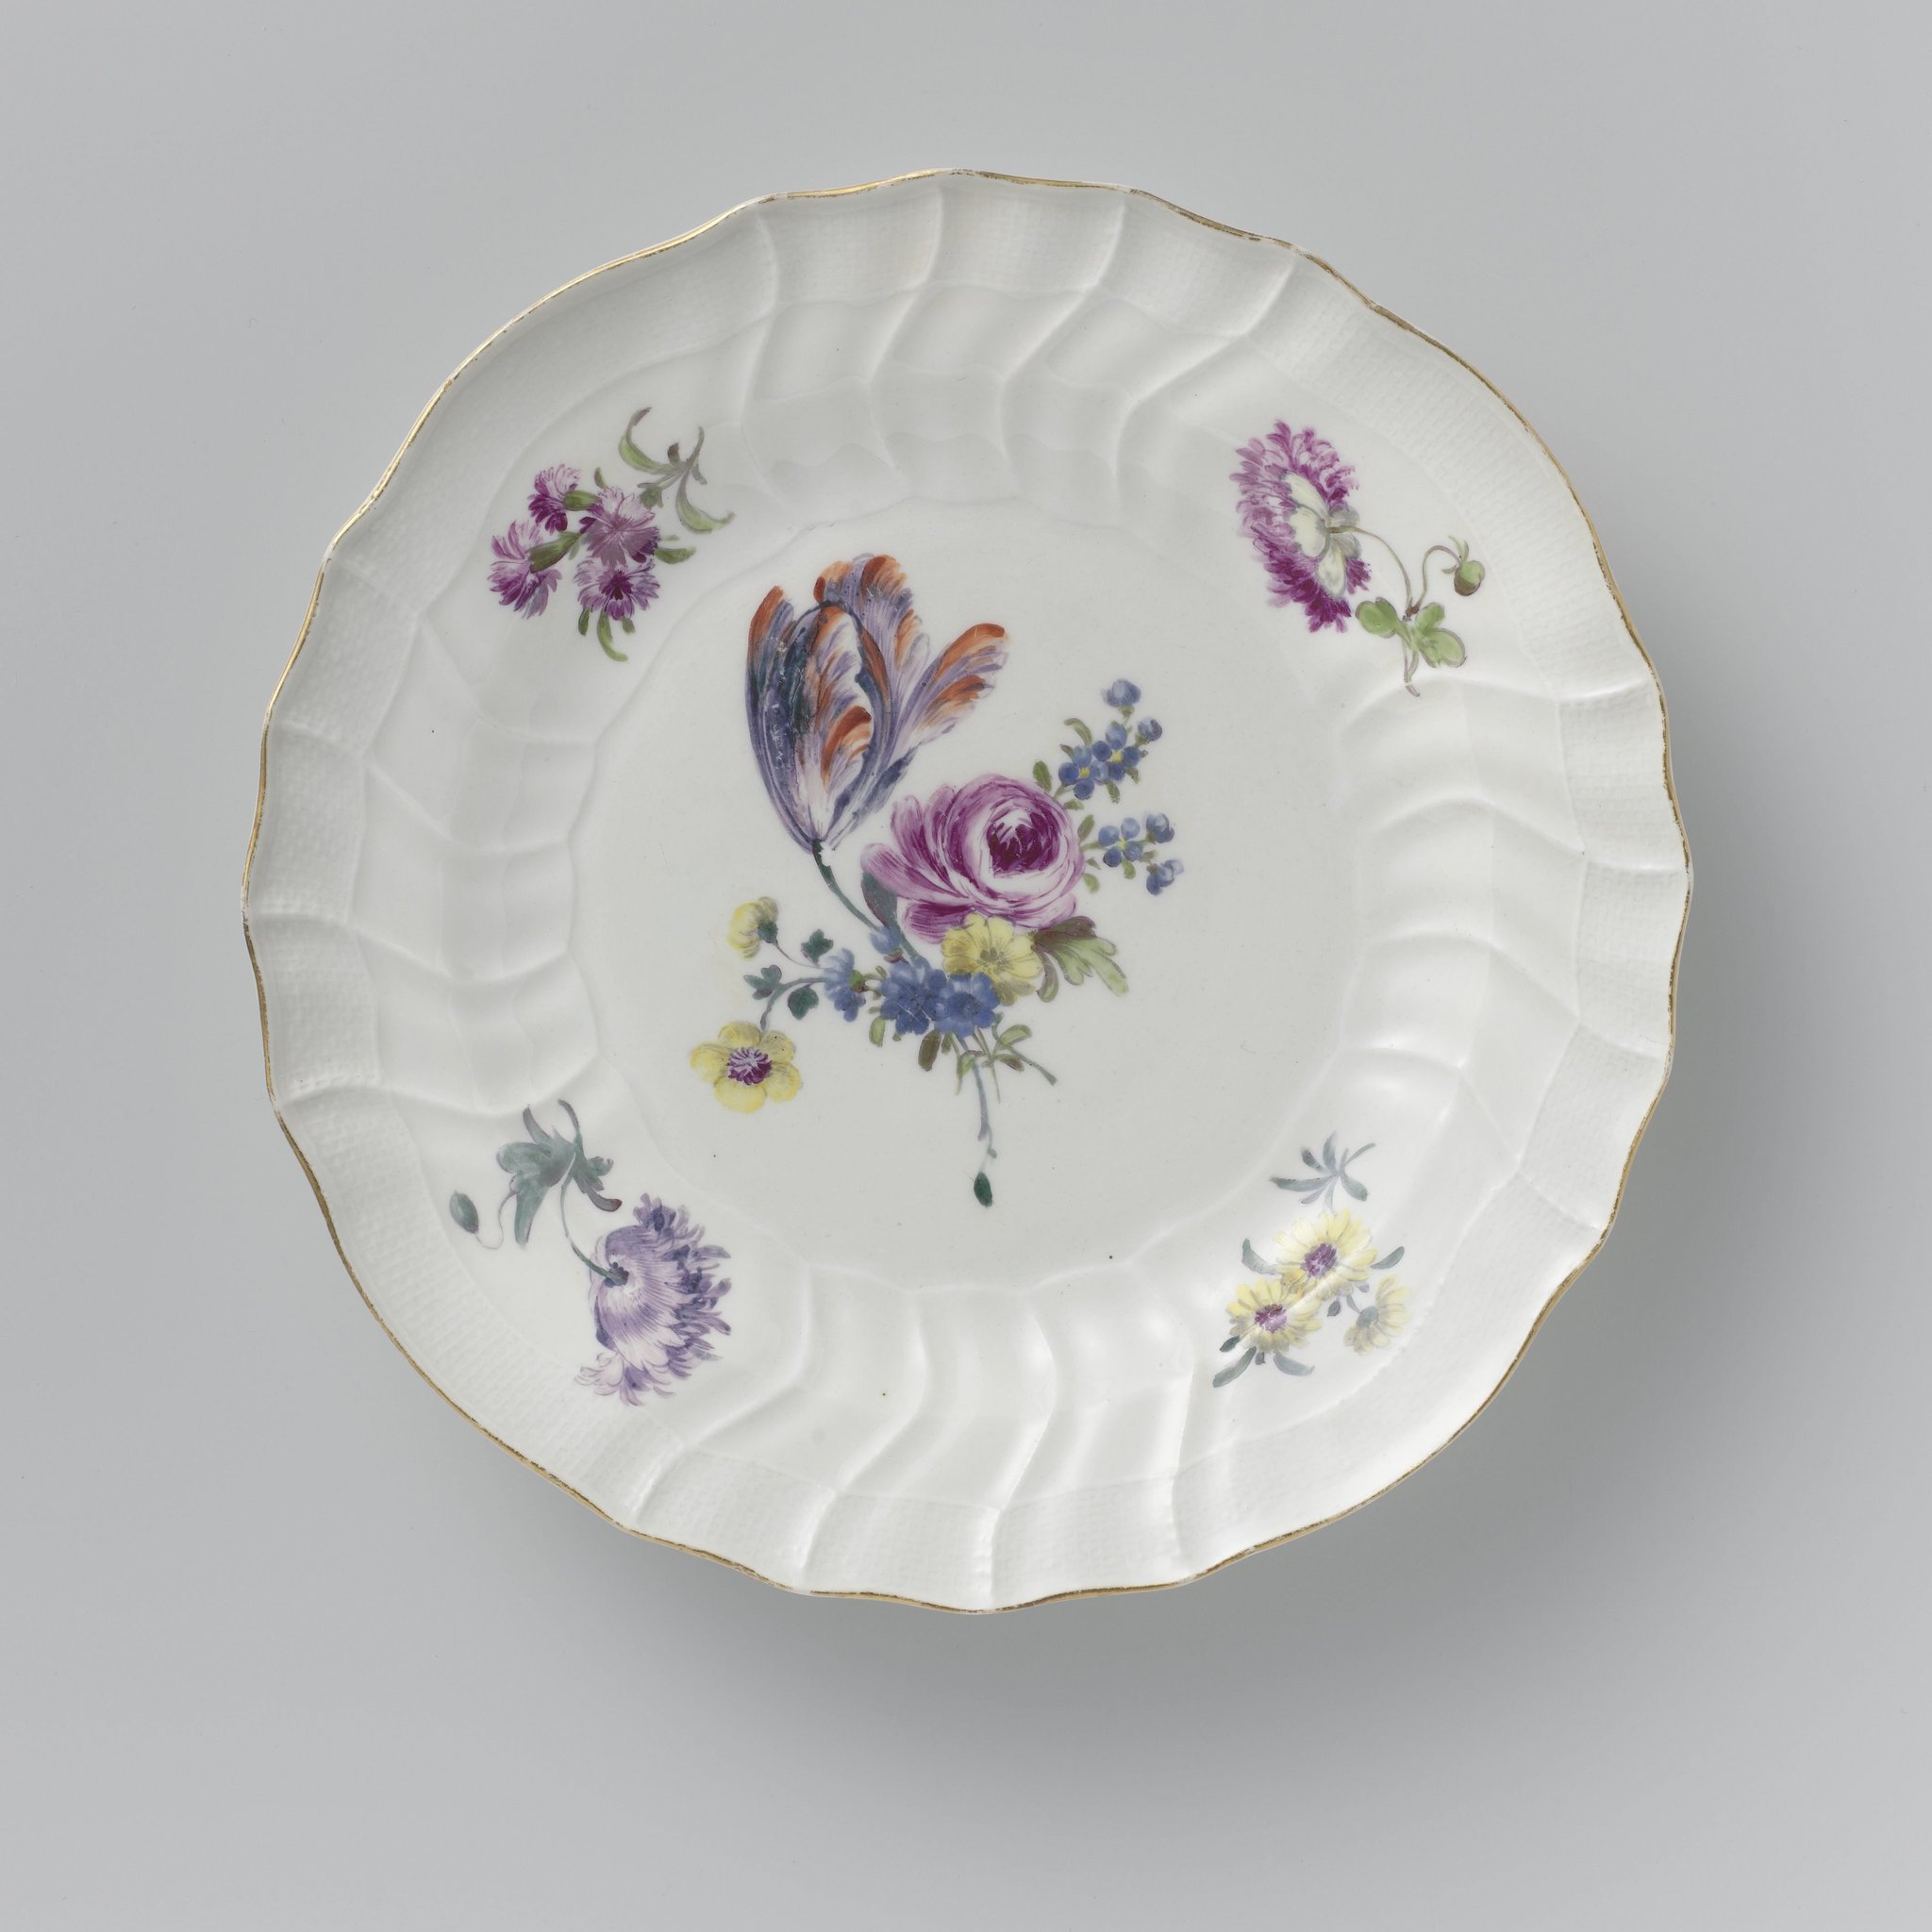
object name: eating drinking utensil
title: Bord, veelkleurig beschilderd met Deutsche Blumen, insekten en vruchten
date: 1750-1760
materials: porcelain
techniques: painted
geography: meissen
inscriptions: factory mark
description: Rond bord van beschilderd porselein. Het bord is beschilderd met Deutsche Blumen, insekten en vruchten. De rand is in reliëf versierd met het Neuozier-patroon. Het bord is gemerkt en hoort bij een servies (BK-17474-1 t/m BK-17474-253).